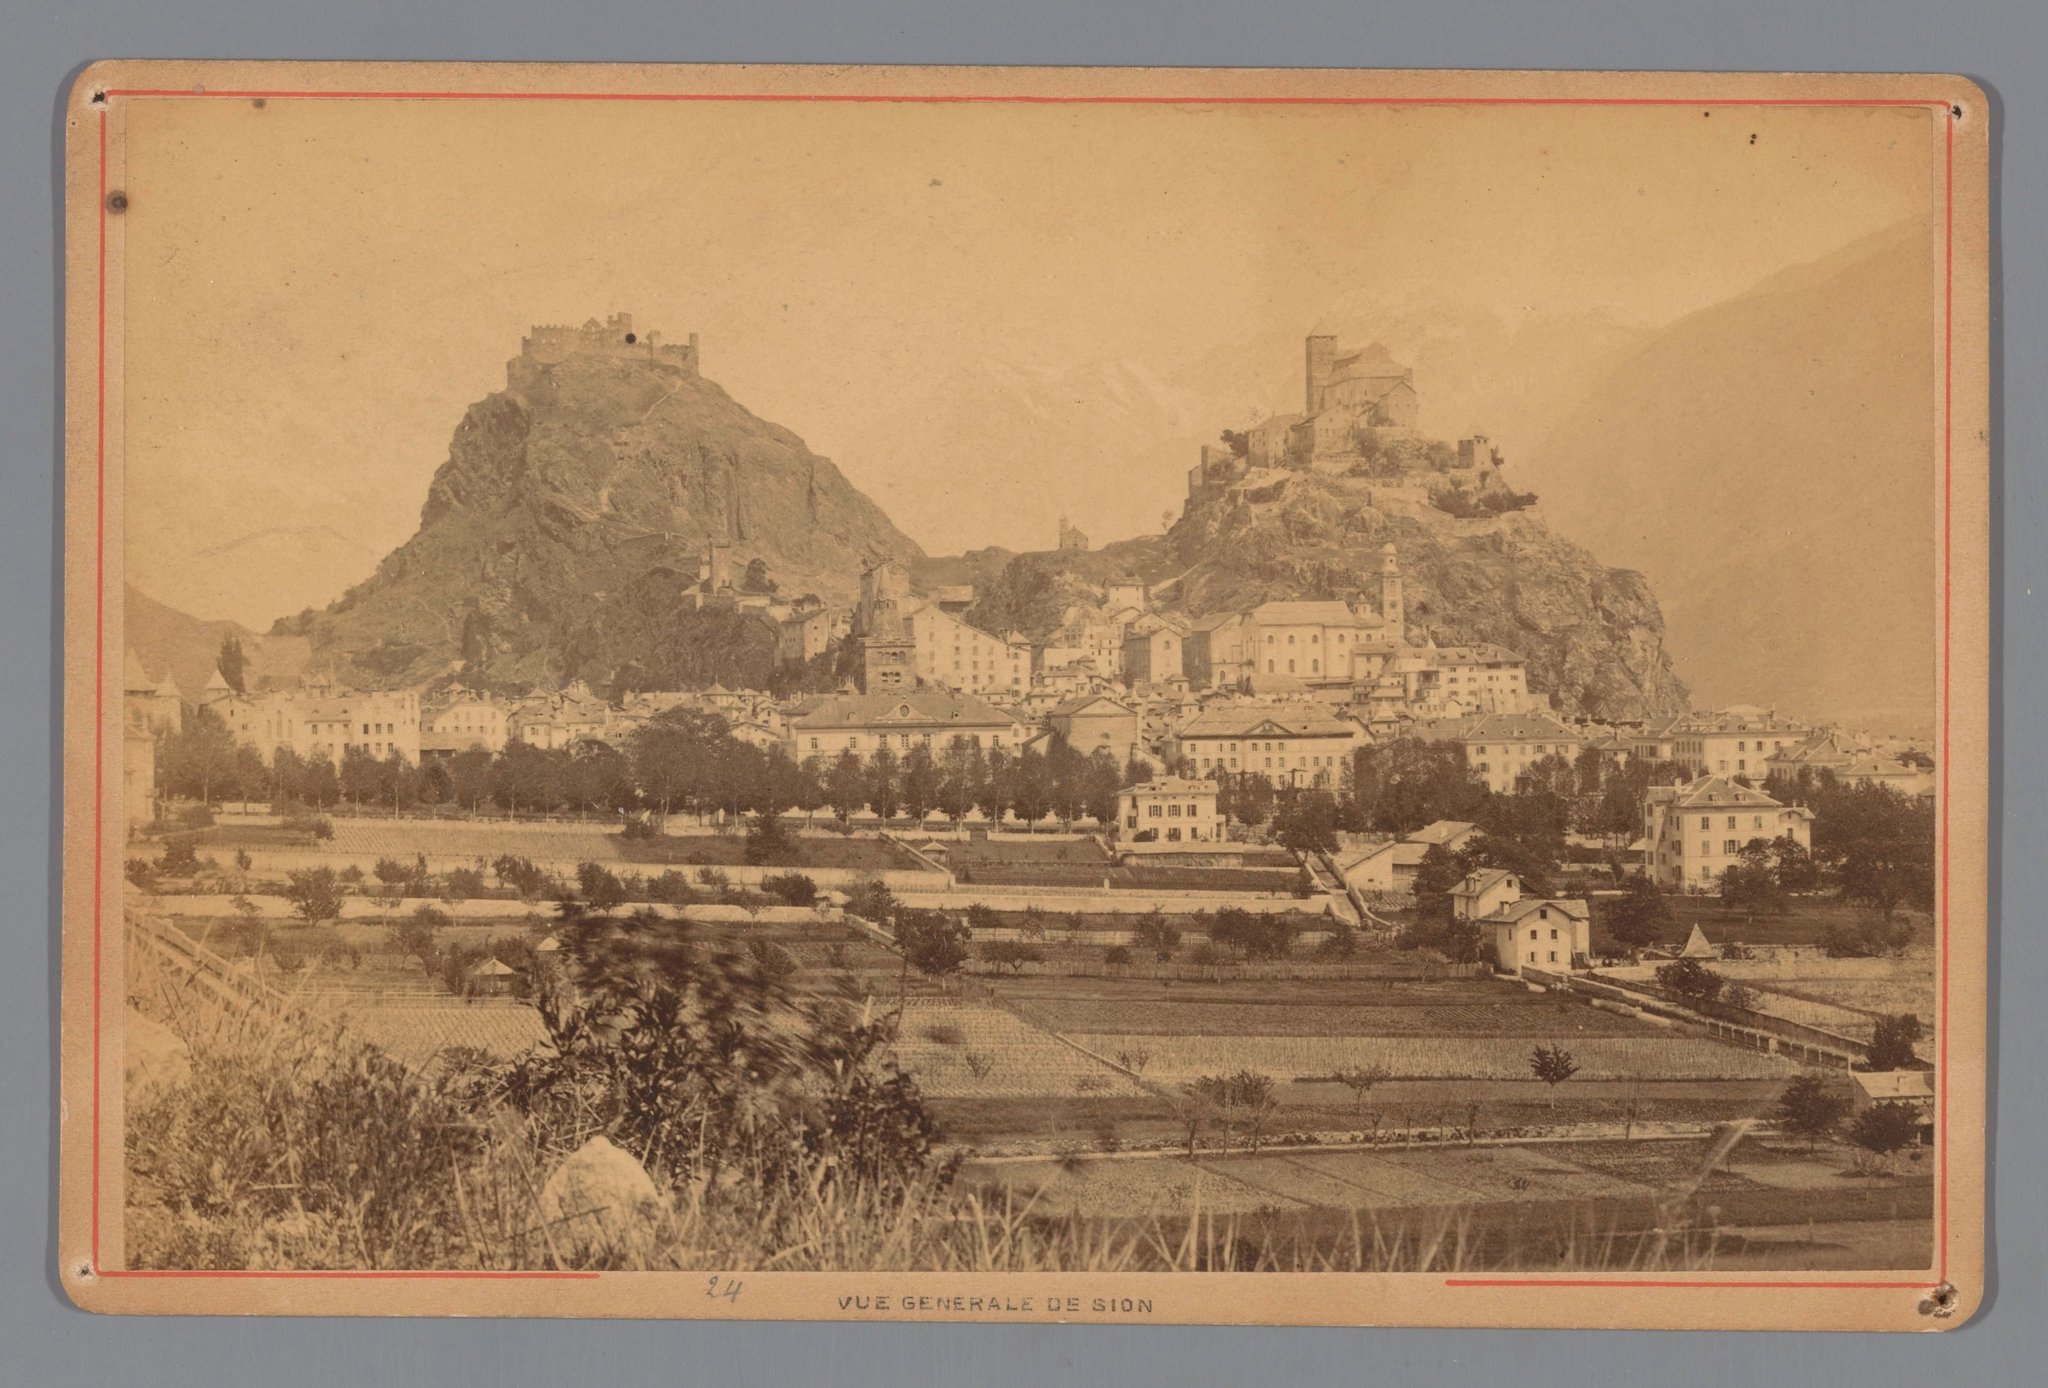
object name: cabinet photograph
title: Gezicht op Sion in Zwitserland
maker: garcin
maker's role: fotograaf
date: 1875-1885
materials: cardboard, photographic support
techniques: albumen print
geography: sion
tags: city-view, and landscape with man-made constructions, rock-formations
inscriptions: number: ‘24’